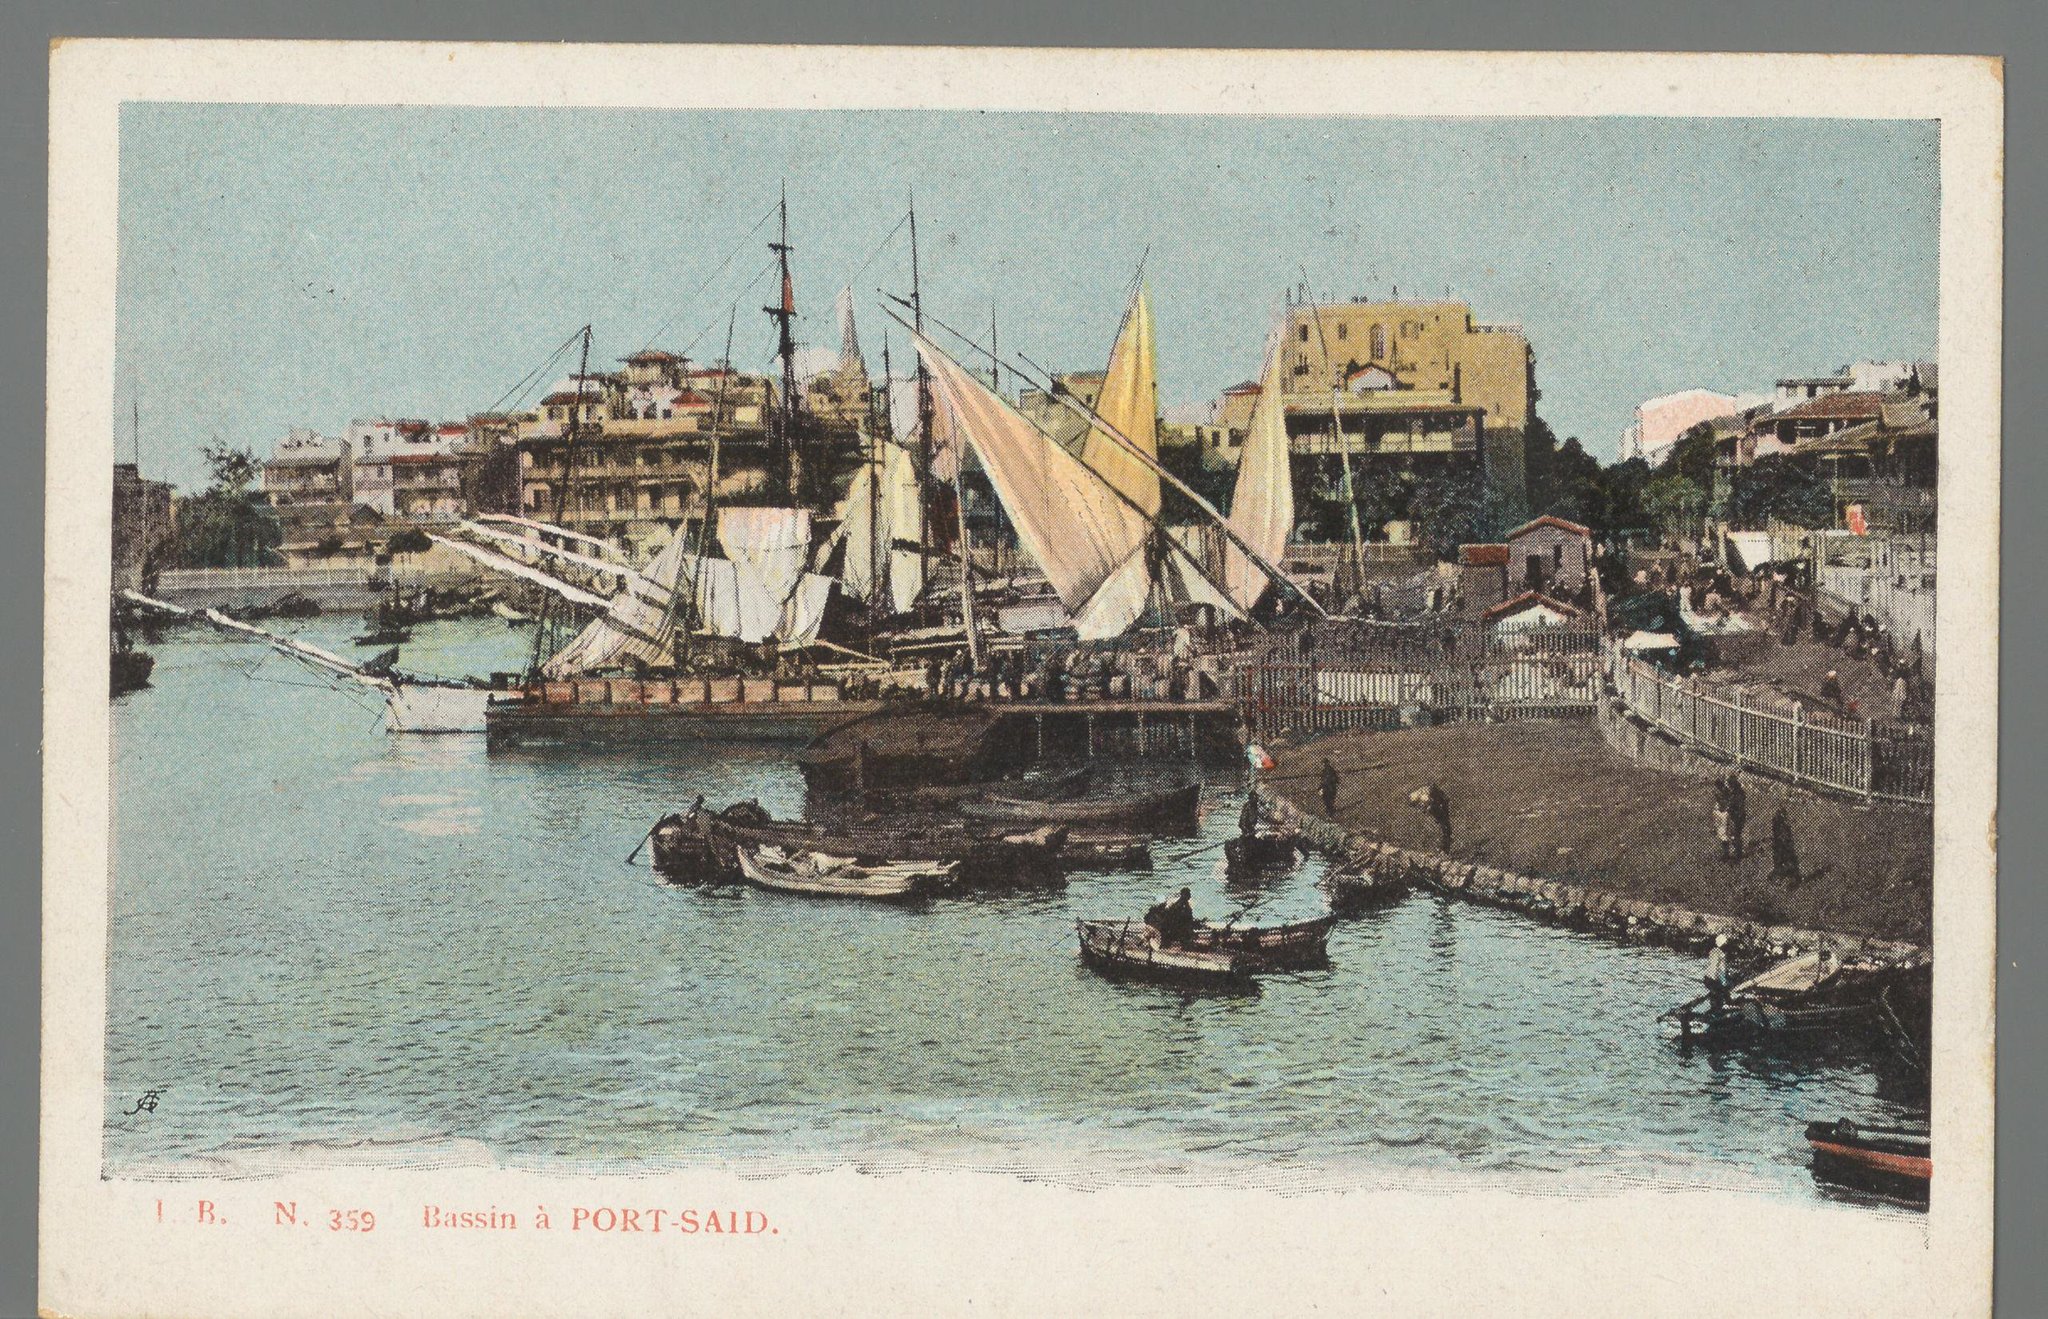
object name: photomechanical print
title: Bassin à Port Said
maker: Anonymous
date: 1907-1930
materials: cardboard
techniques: lithograph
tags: ships (in general), pond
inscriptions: monogram: ‘AG’, inscription: ‘I. B. - N.’